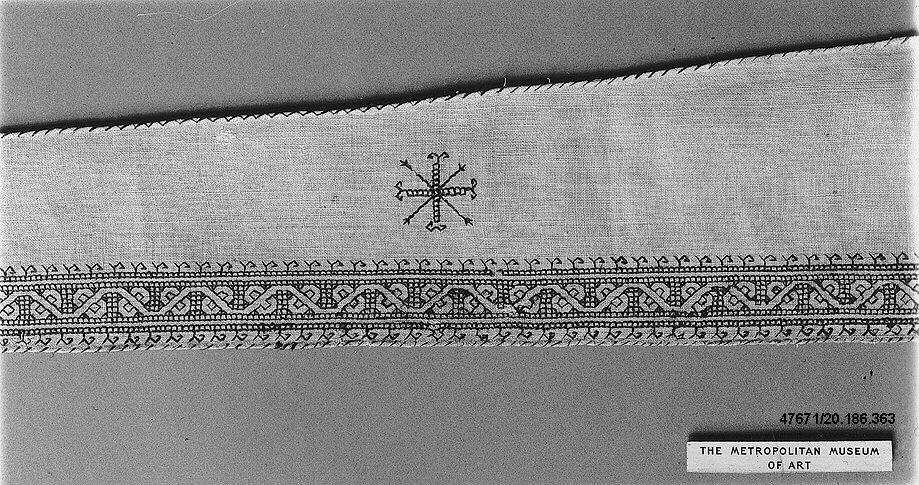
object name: swaddling band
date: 1501-1600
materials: linen